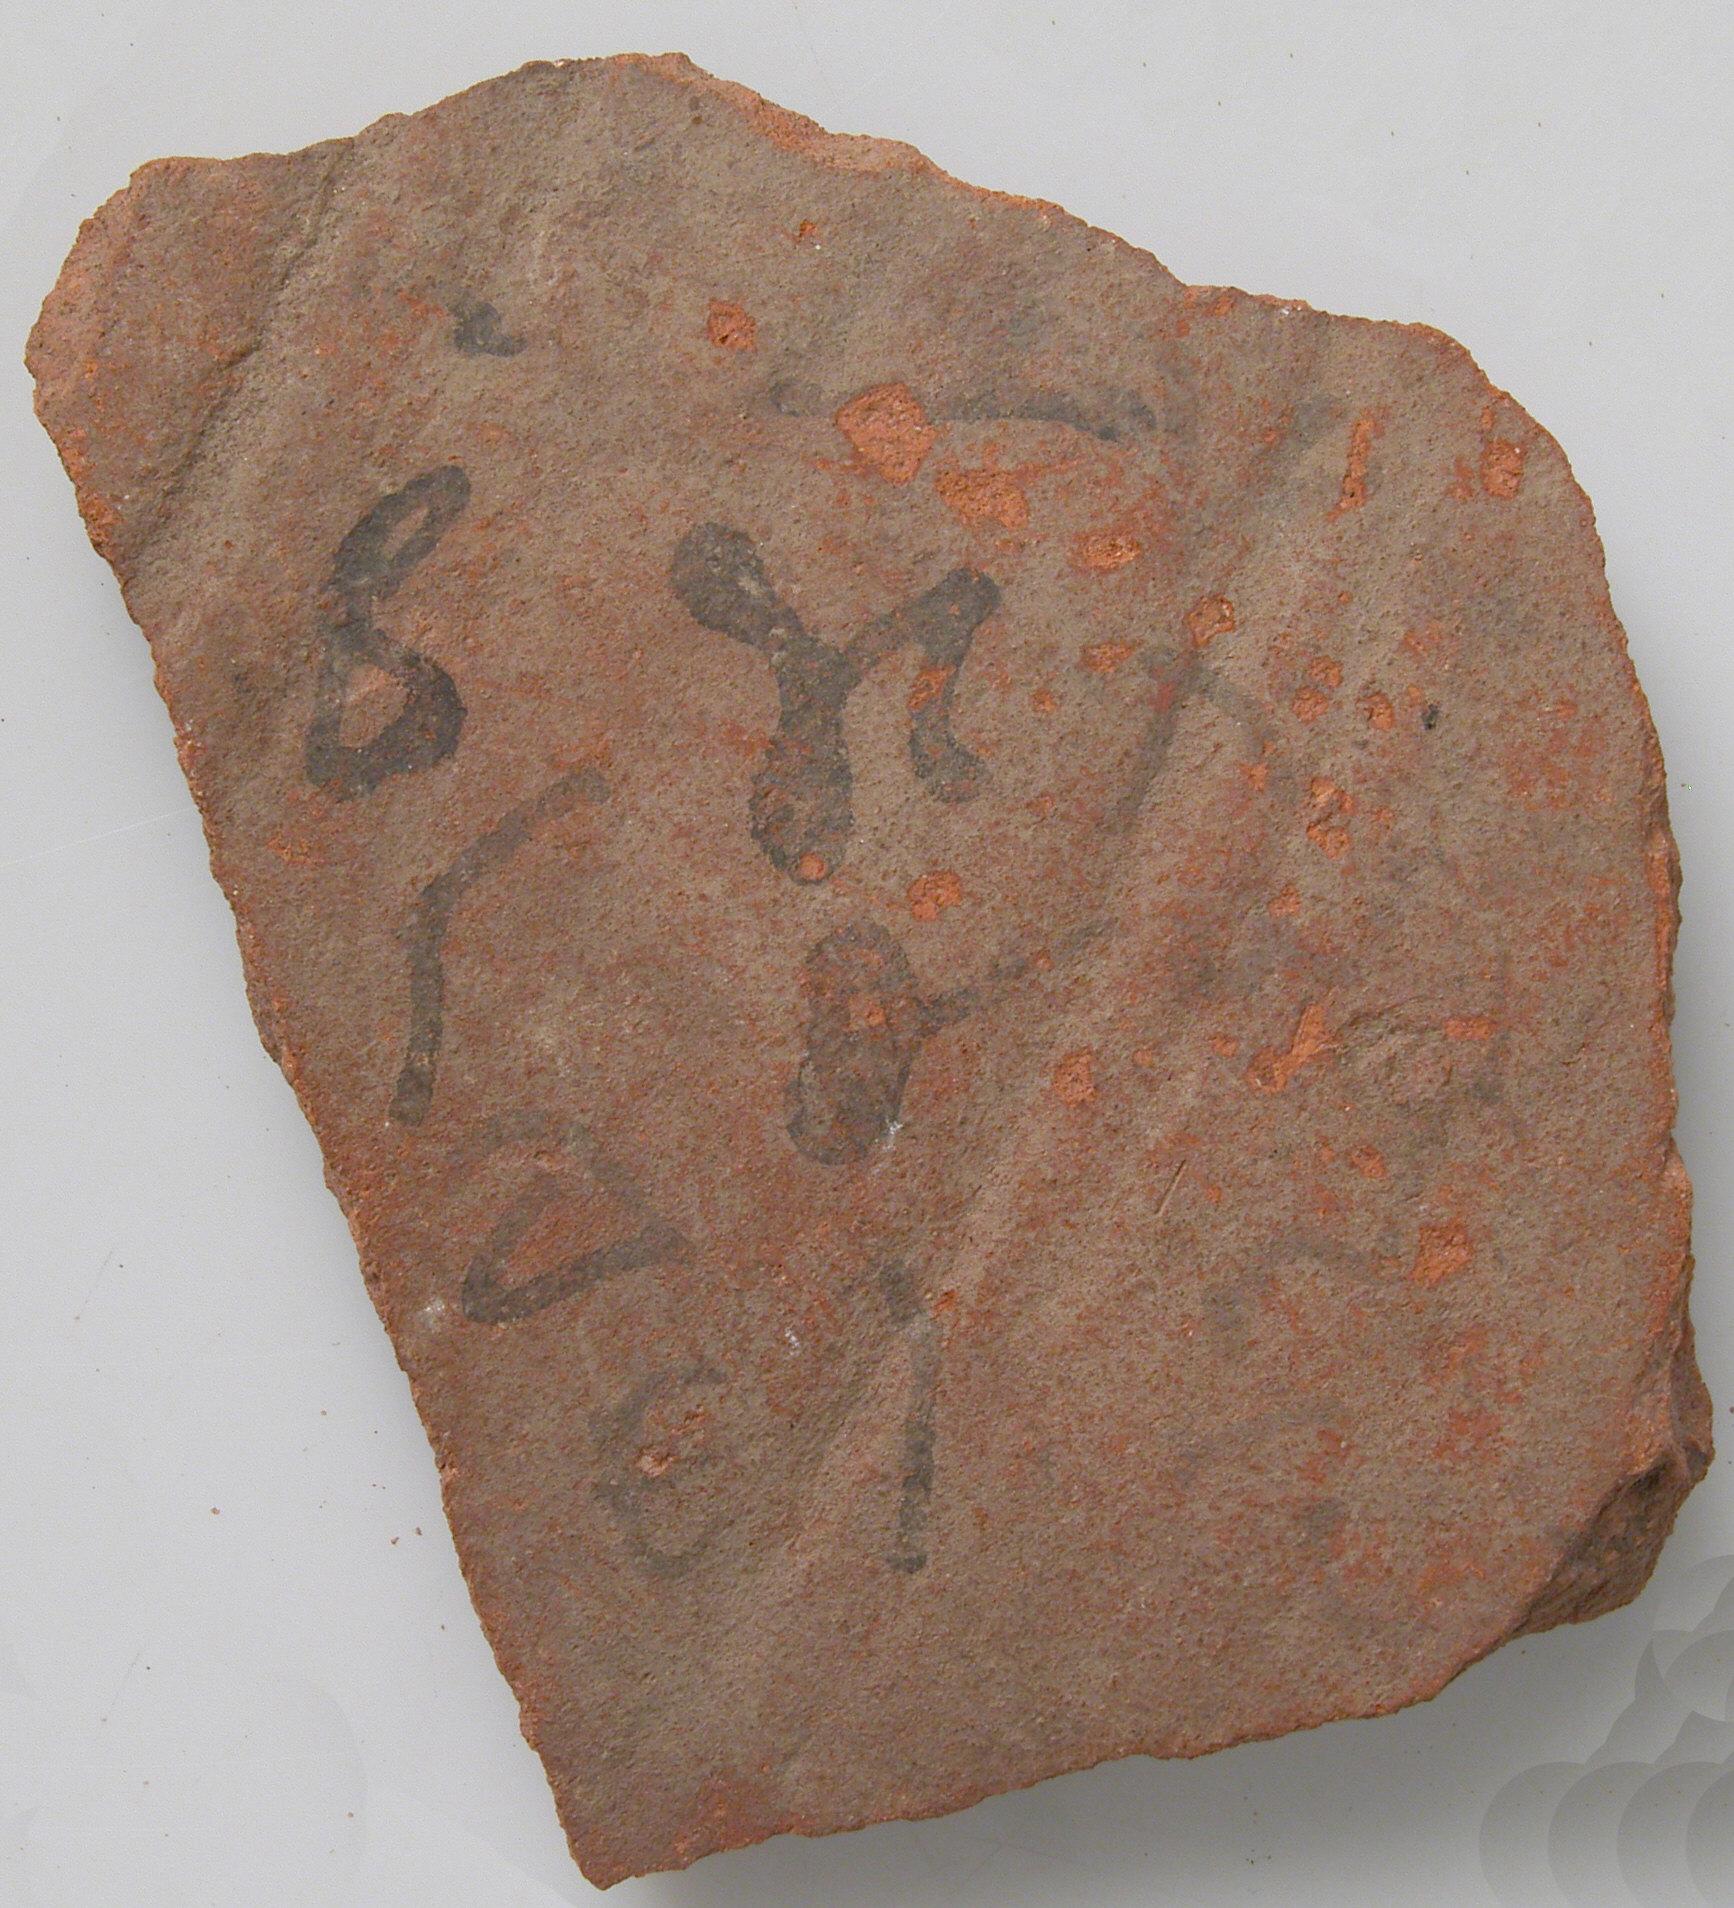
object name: ostrakon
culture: coptic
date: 301-700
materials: ink, pottery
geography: egypt